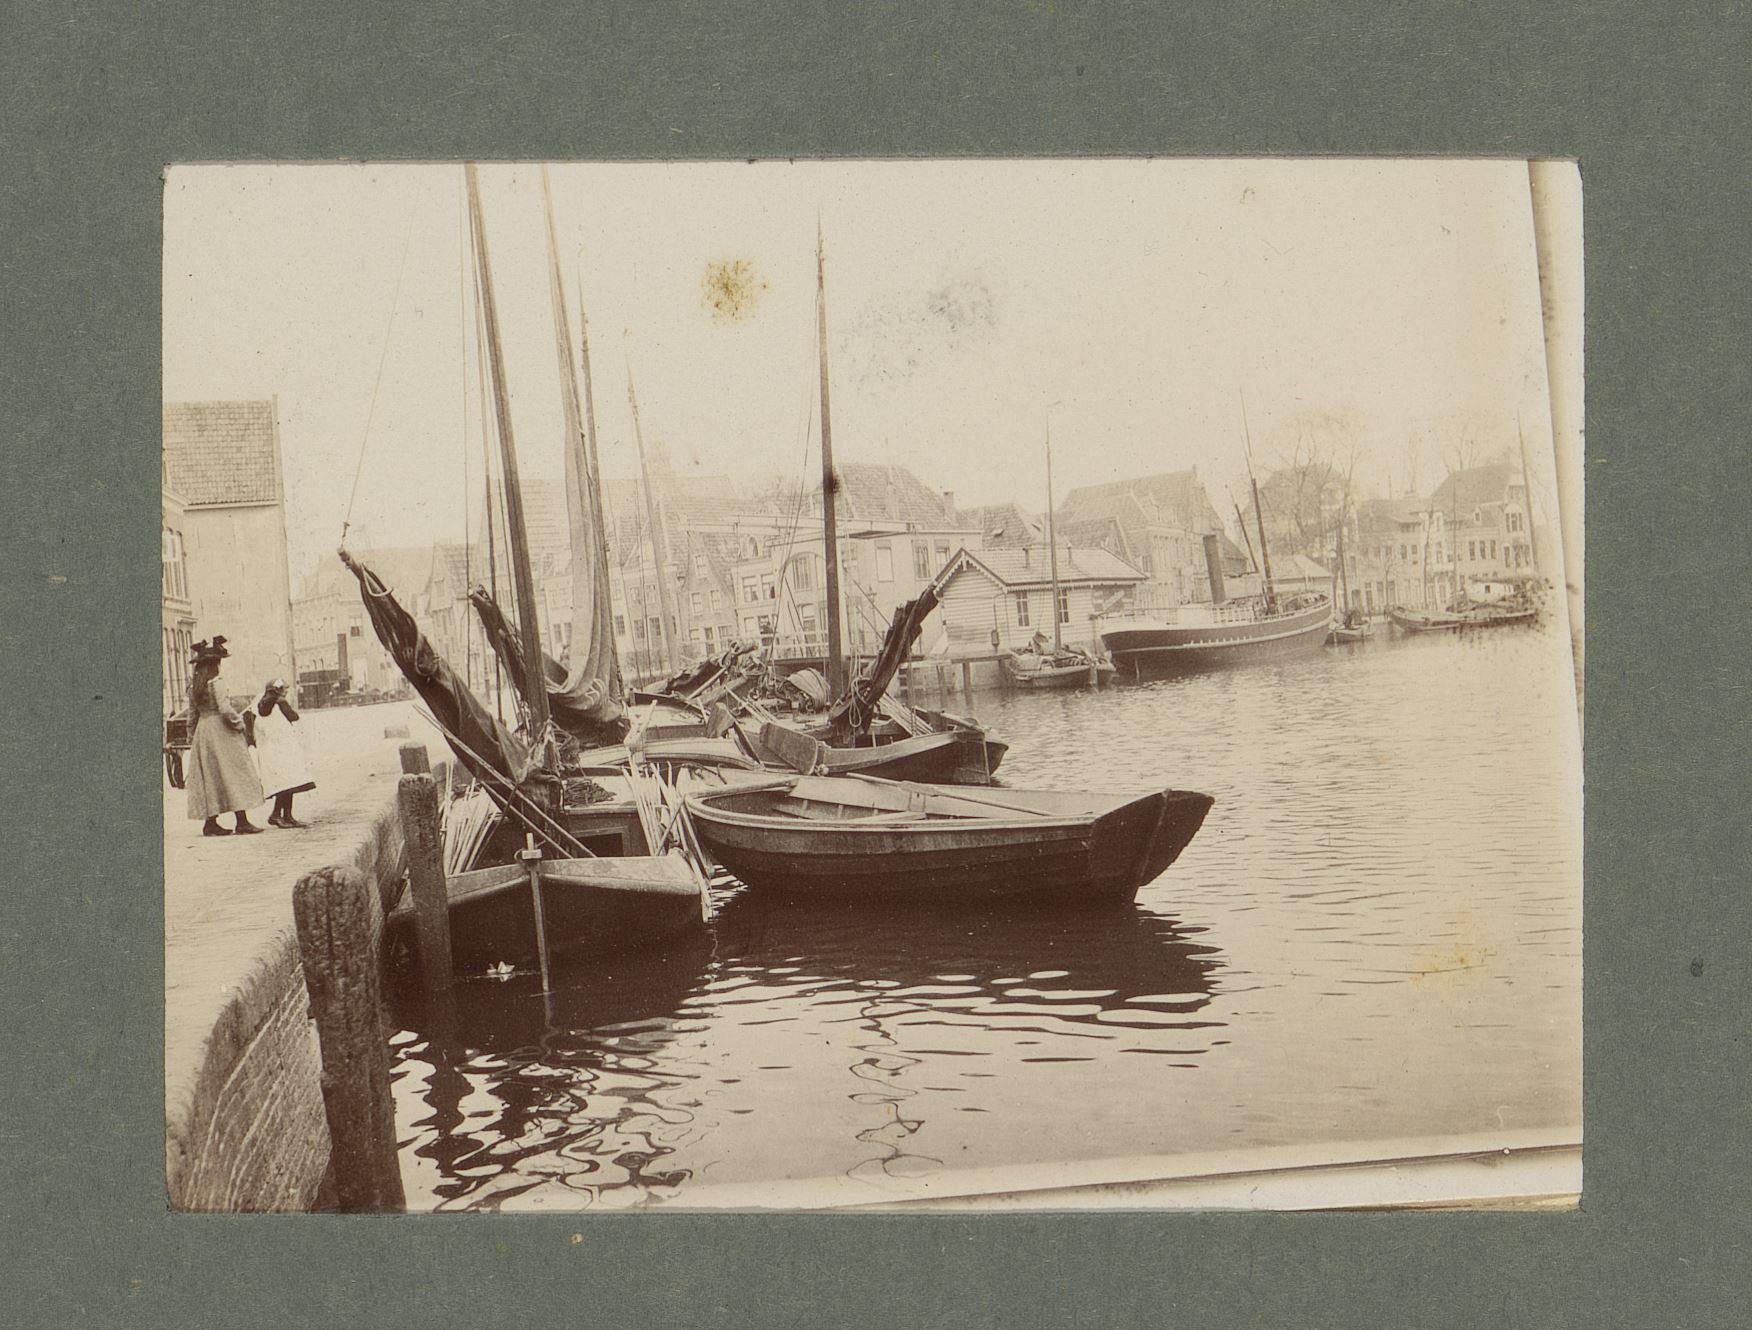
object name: album leaf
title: Aangemeerde zeil- en roeiboten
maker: george hidderley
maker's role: fotograaf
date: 1920-1940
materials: photographic support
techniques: gelatin silver print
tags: sailing-ship, sailing-boat, rowing-boat, canoe, etc.